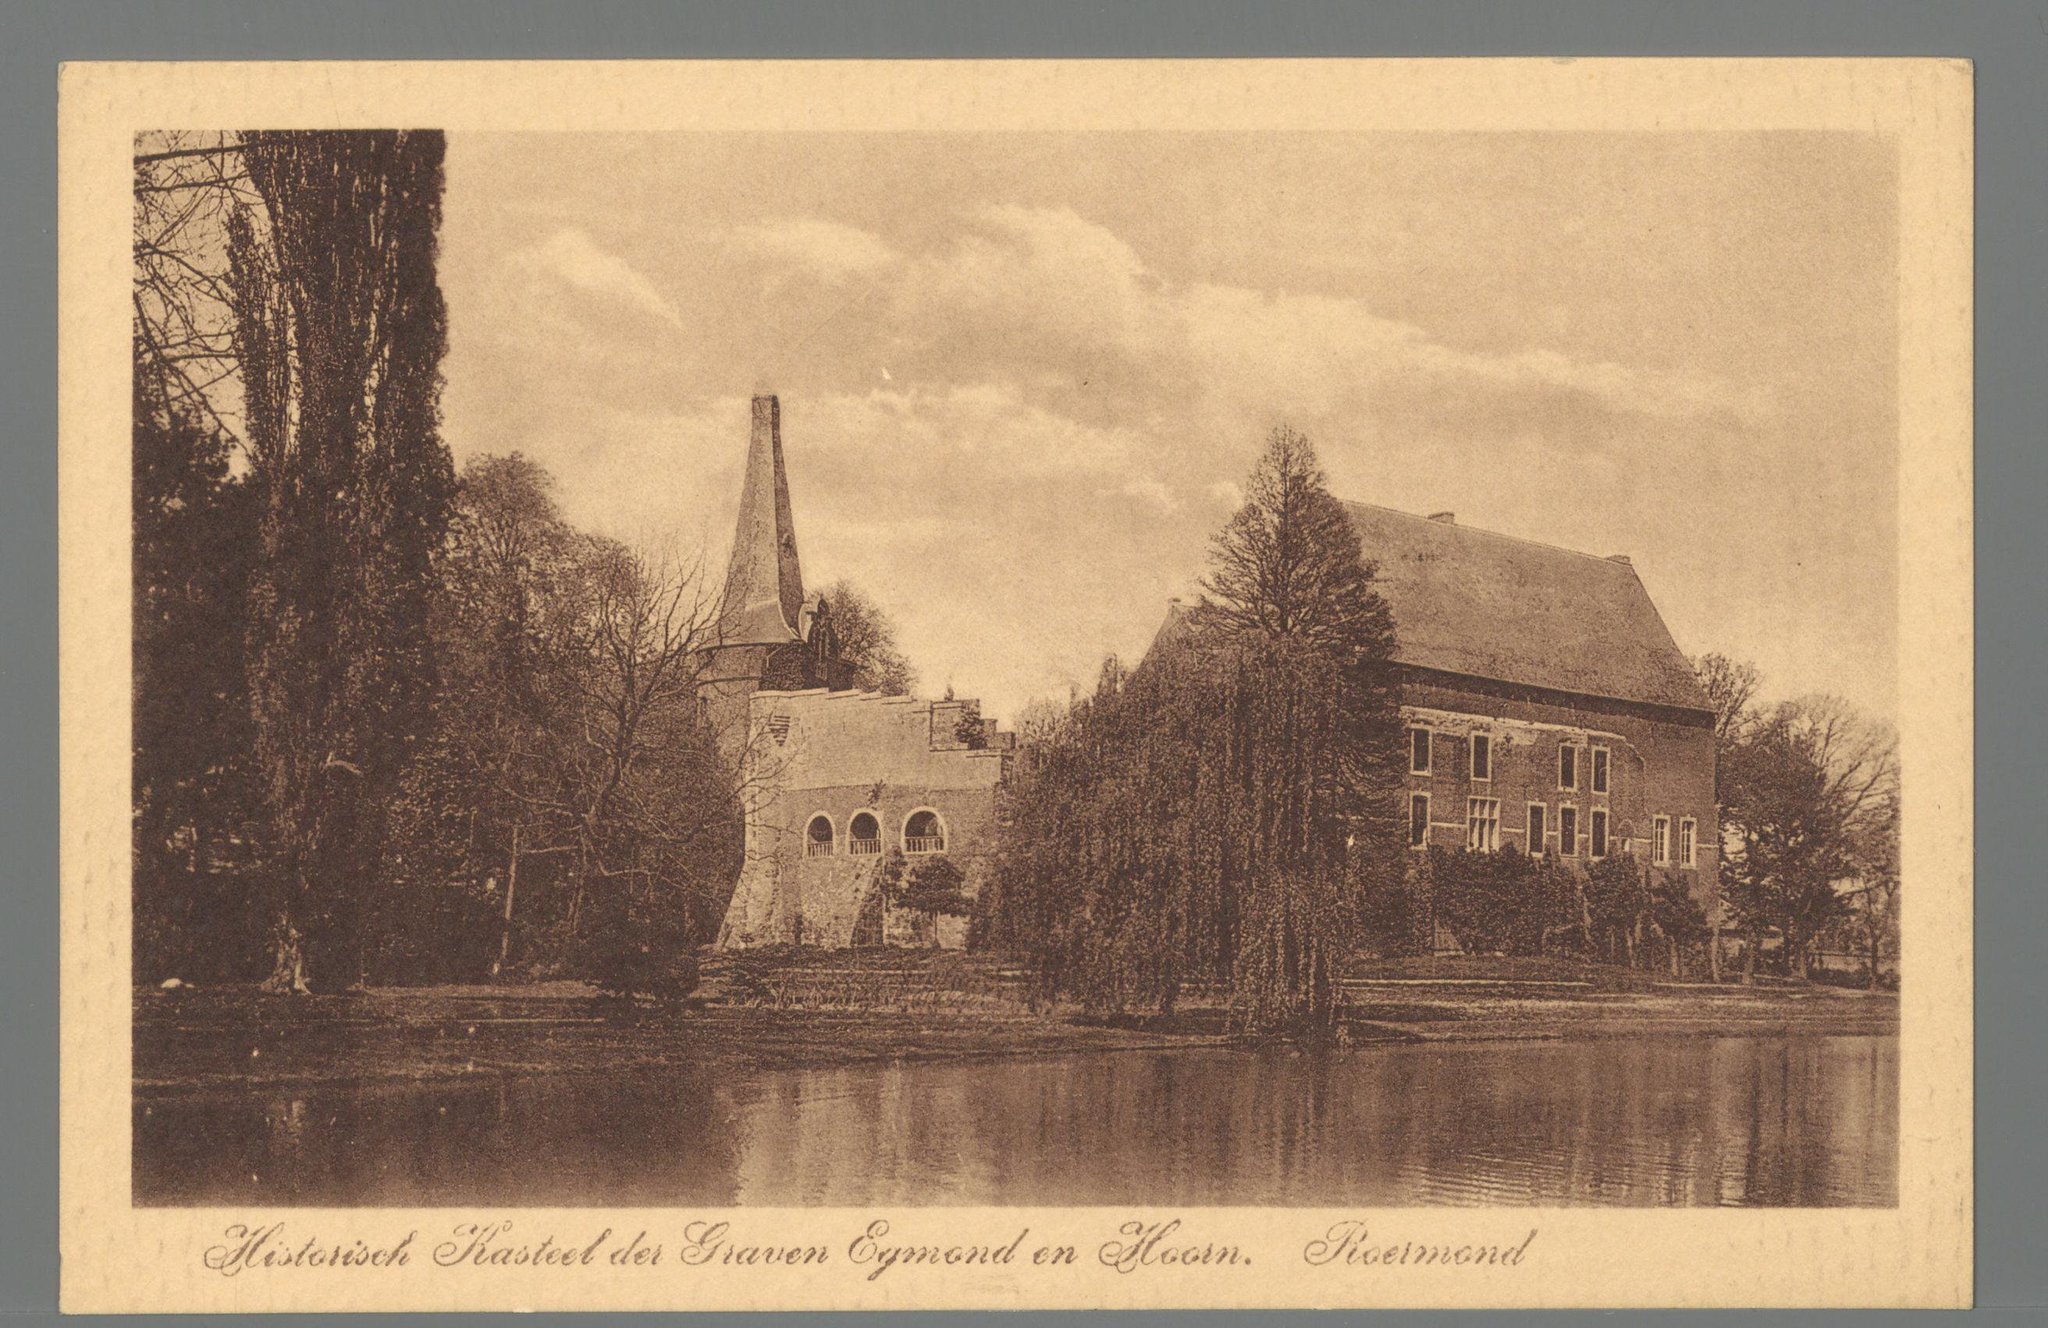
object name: photomechanical print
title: Historisch Kasteel der Graven Egmond en Hoorn. Roermond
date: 1913-1950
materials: cardboard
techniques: photograph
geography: horn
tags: castle, pond